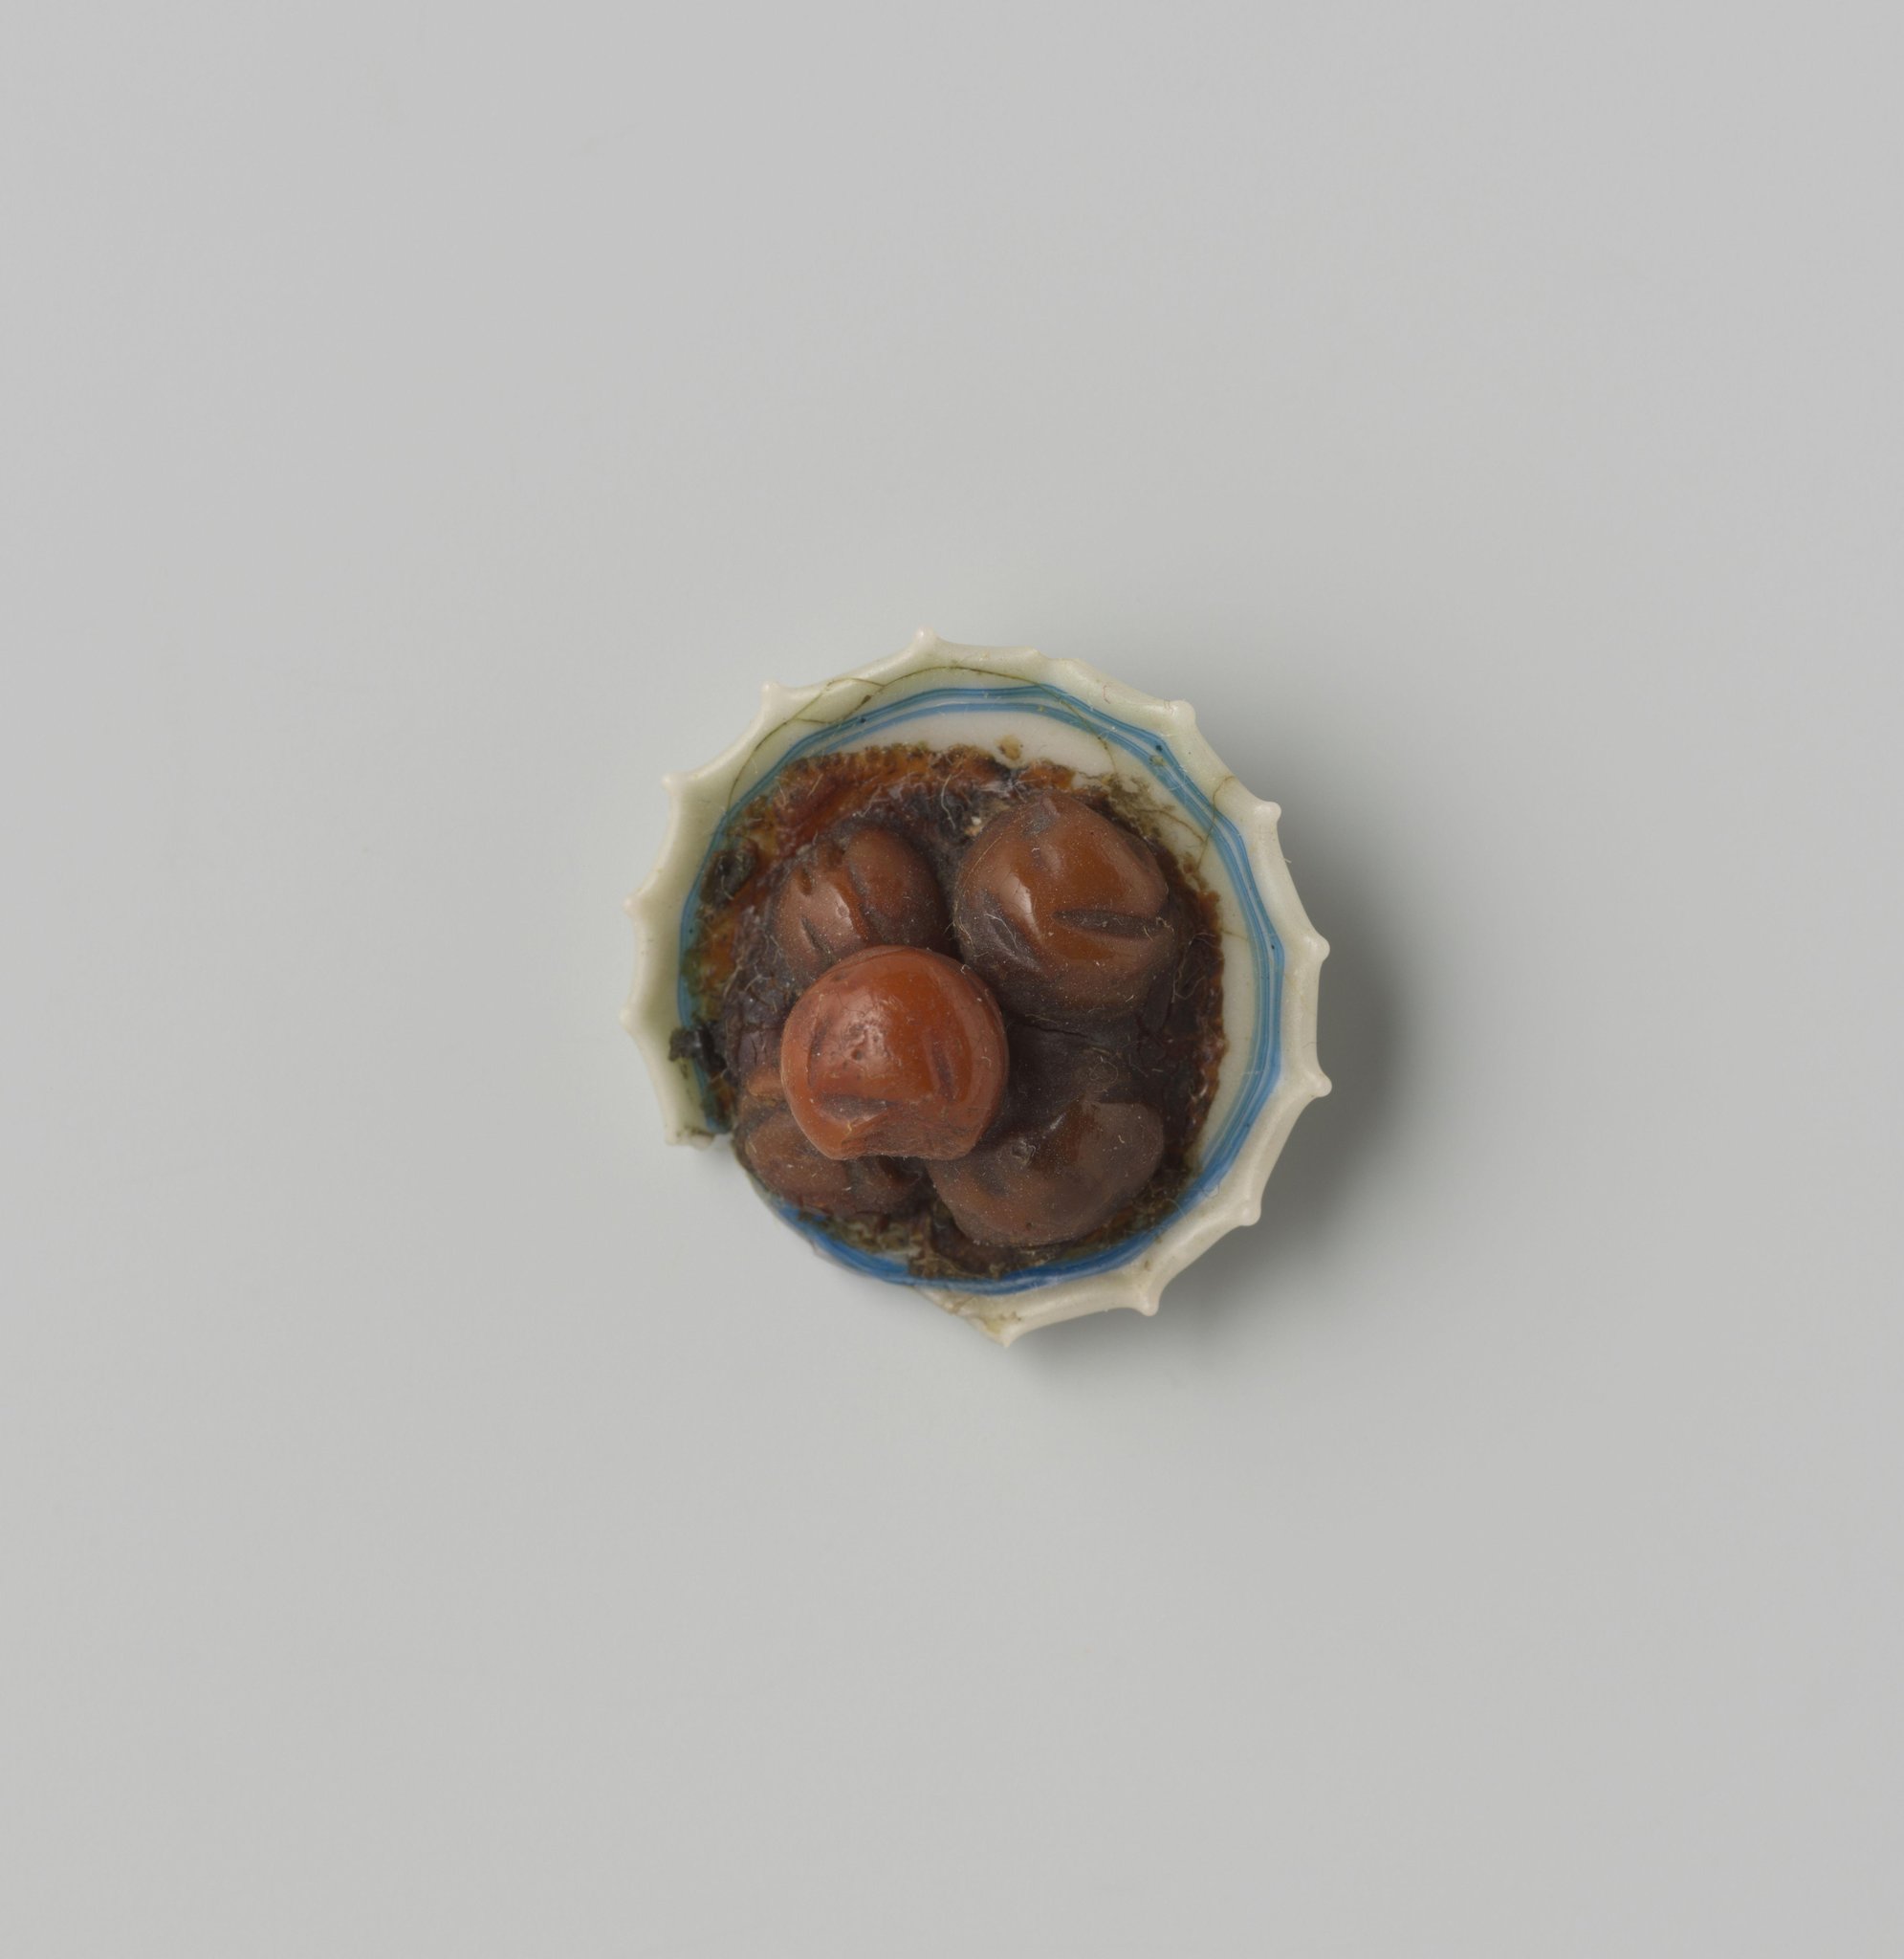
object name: miniature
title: Schotel van melkglas met blauwe emailverf beschildering, imitatie Chinees porselein; dubbelwandige schotel, de rand in punten geknepen.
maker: Anonymous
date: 1675-1710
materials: glass, wax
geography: amsterdam